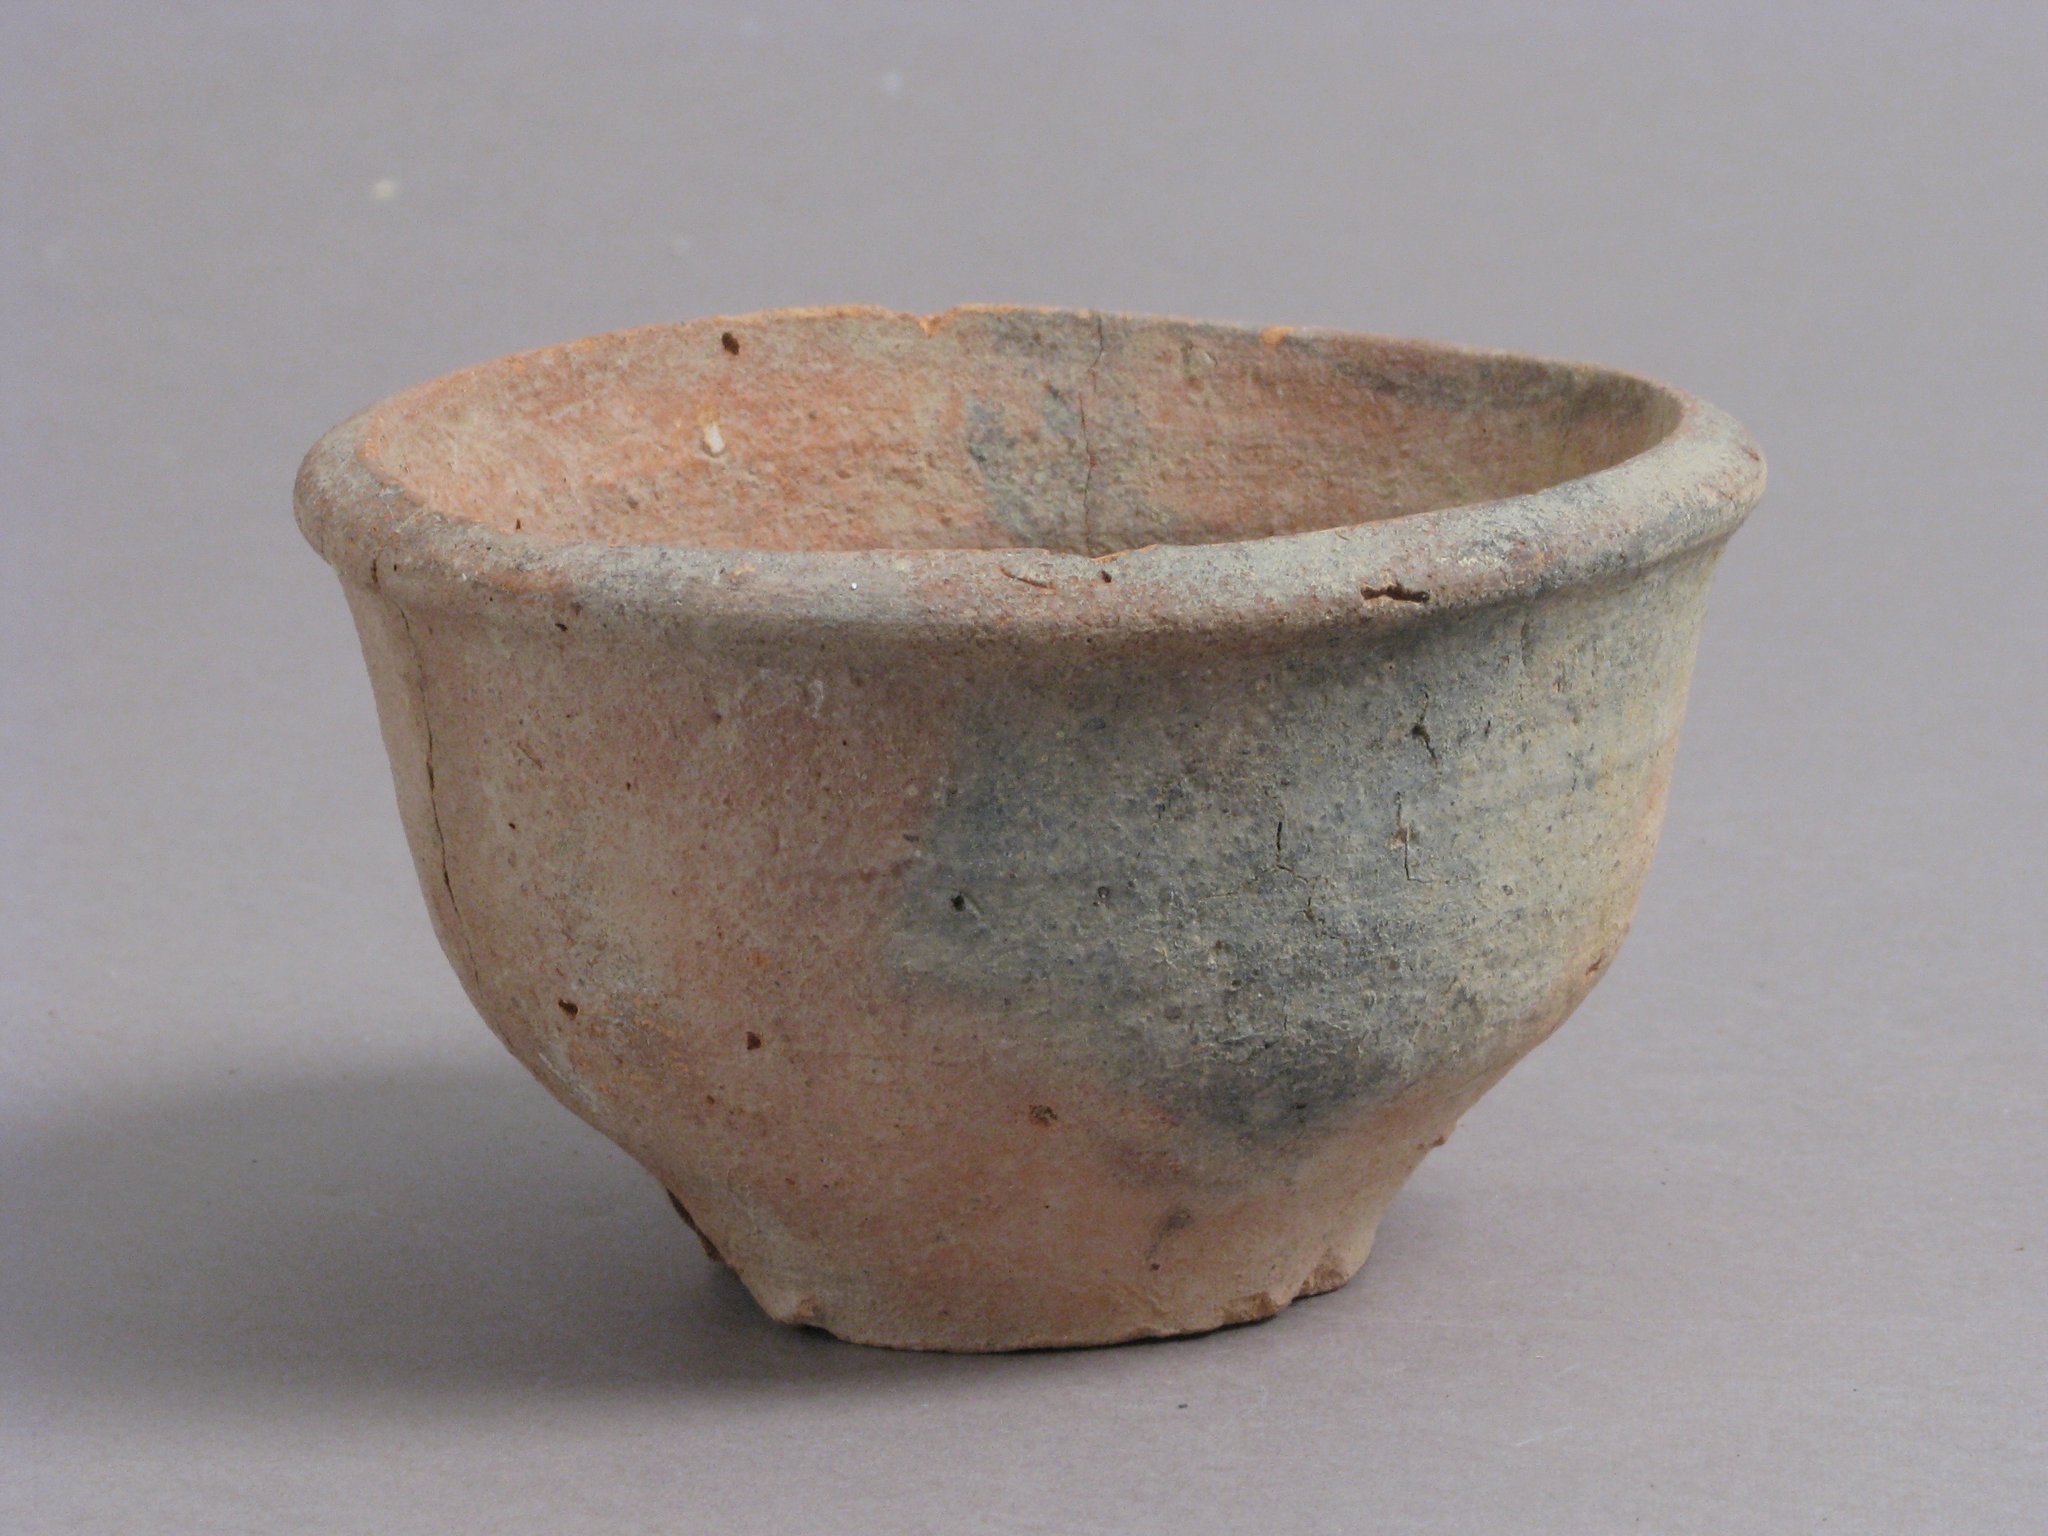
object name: bowl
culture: coptic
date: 301-700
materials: earthenware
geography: egypt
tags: bowls